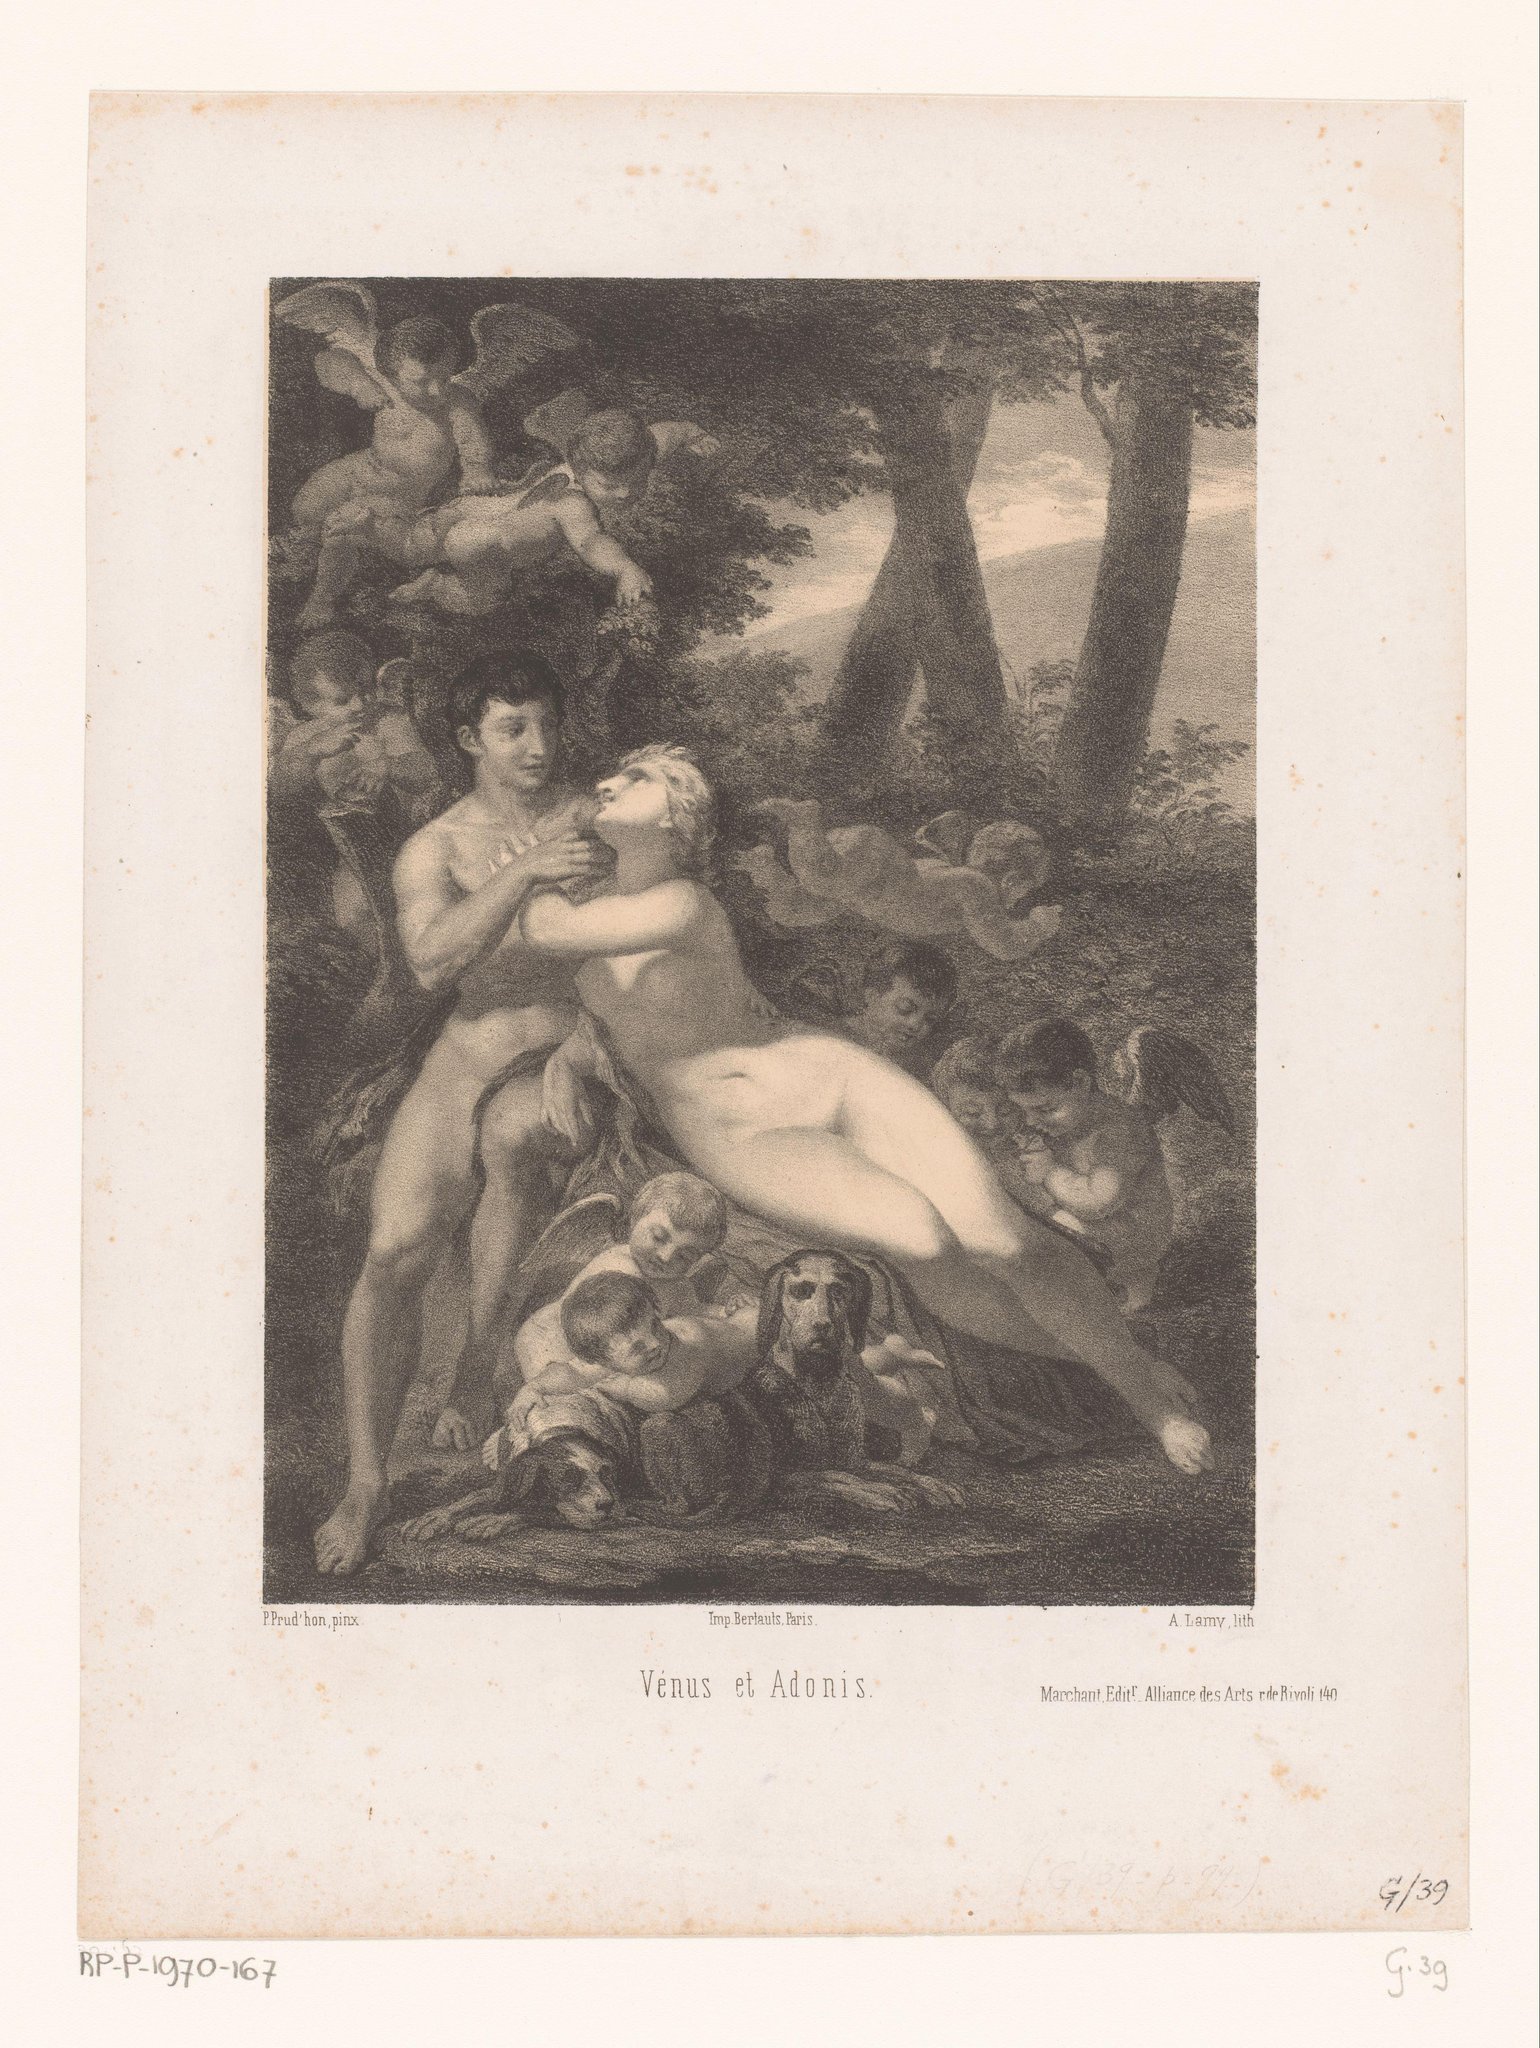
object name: print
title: Venus en Adonis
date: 1820-1881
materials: paper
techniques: lithograph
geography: paris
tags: venus and adonis as lovers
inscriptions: collector's mark: Lugt 2760, collector's mark: Lugt 2228a